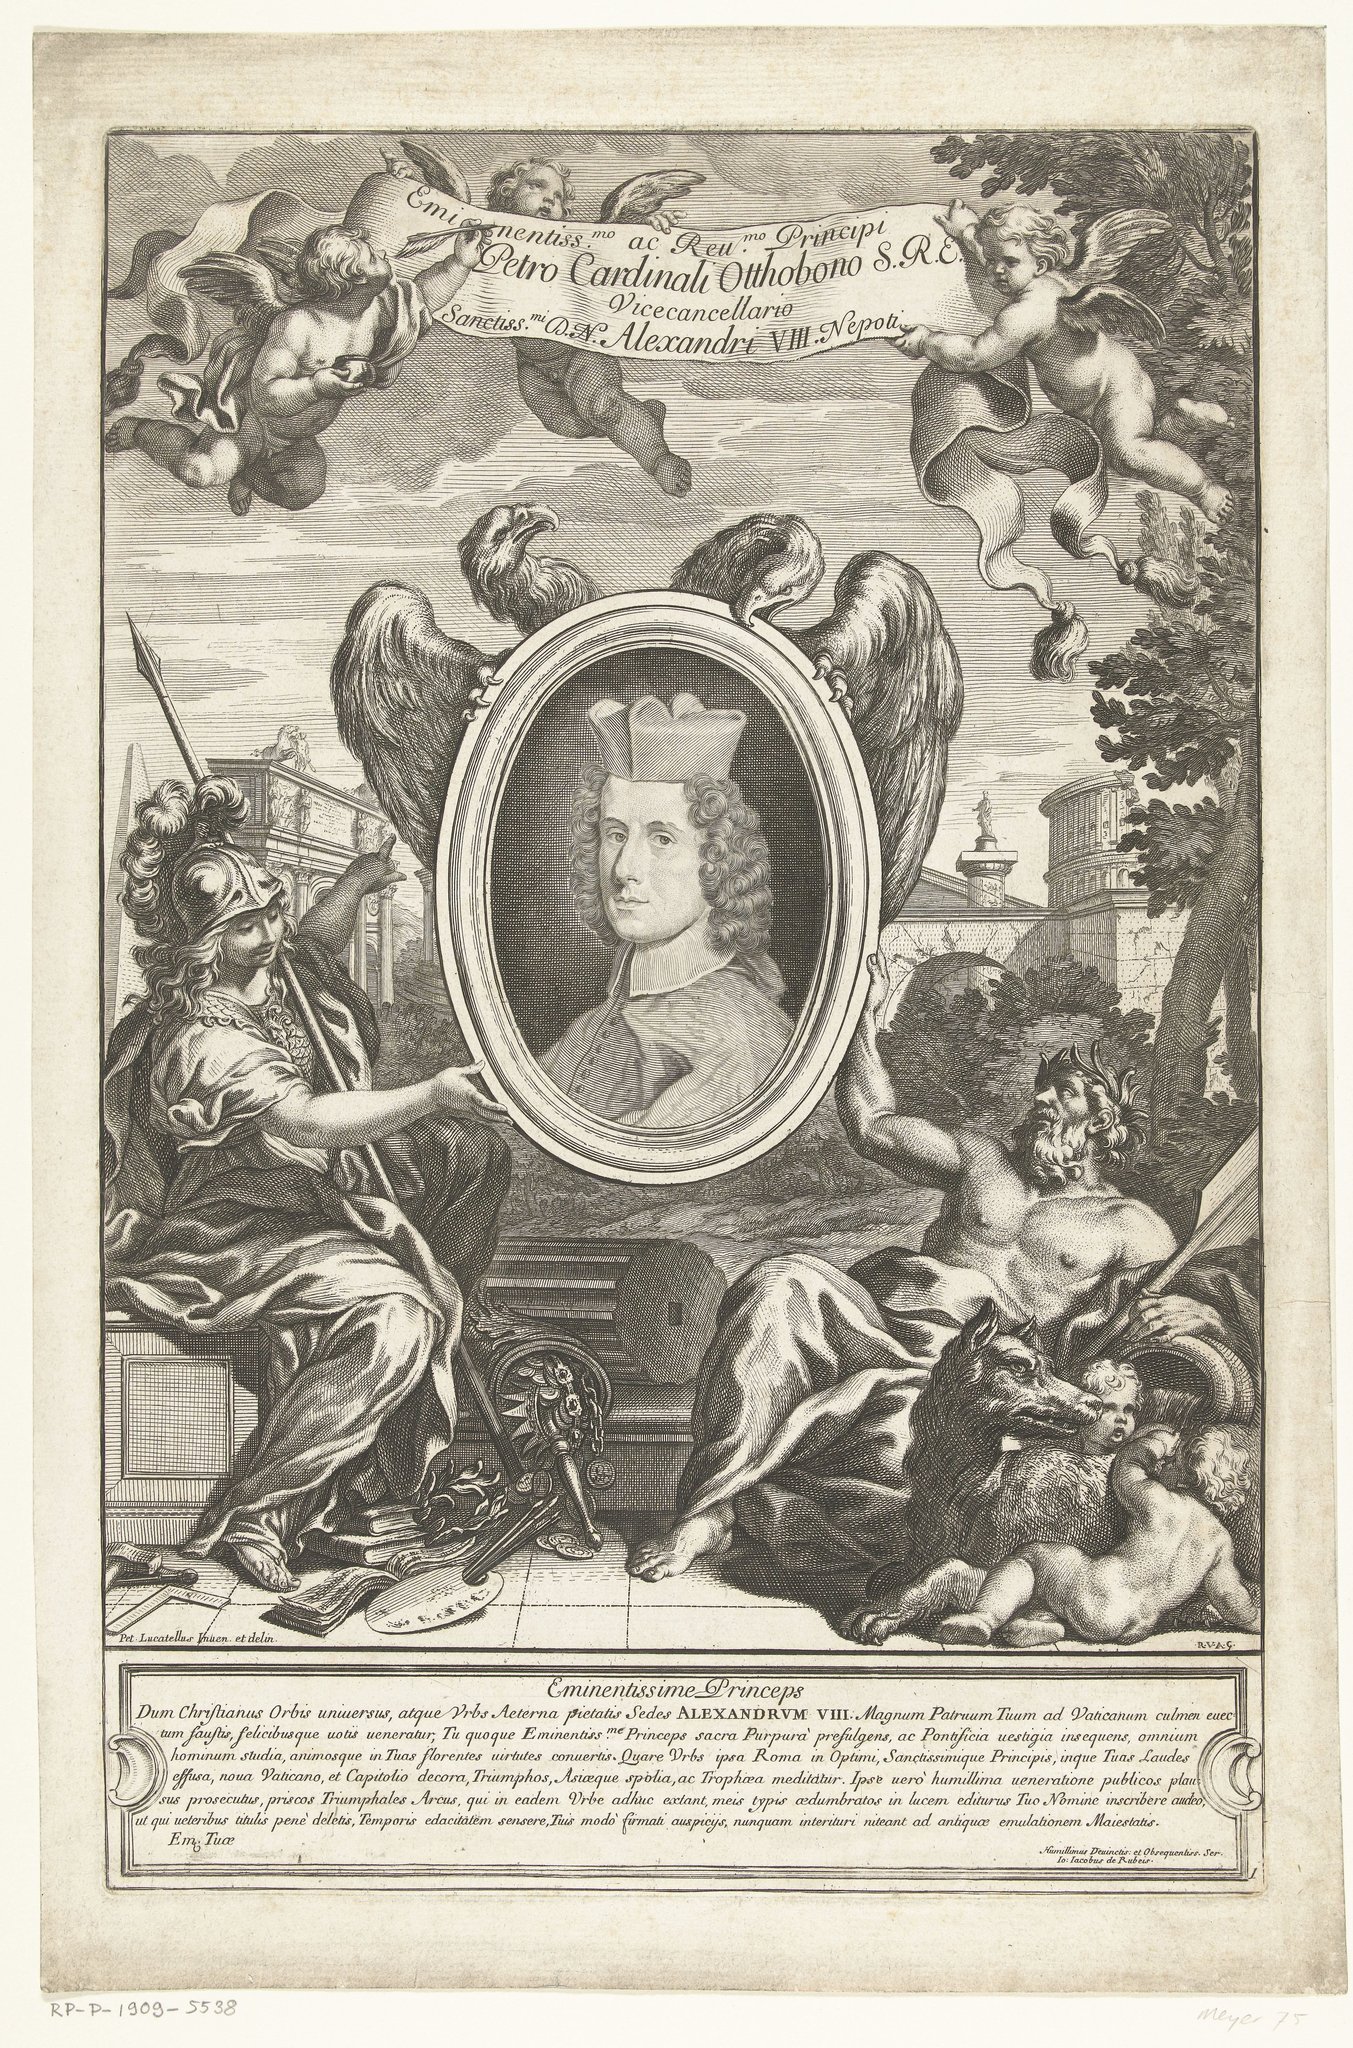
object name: print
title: Portret van kardinaal Pietro Ottoboni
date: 1685-1691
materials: paper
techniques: engraving, etching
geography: rome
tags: venice, rome, pietro ottoboni (1667-1740), double-headed eagle, (story of) minerva (pallas, athena), romulus and remus are washed ashore and suckled by a she-wolf; 'lupa romana', personification of river tiber; 'tevere' (ripa)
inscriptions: collector's mark: Lugt 2228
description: Borstbeeld van kardinaal Pietro Ottoboni in ovaal. Rond het portret een figuratieve omlijsting met afbeeldingen van Minerva, Romulus en Remus, de gepersonifieerde Tiber en een tweehoofdige adelaar die het portret vasthoudt. Op de achtergrond is Rome te zien.